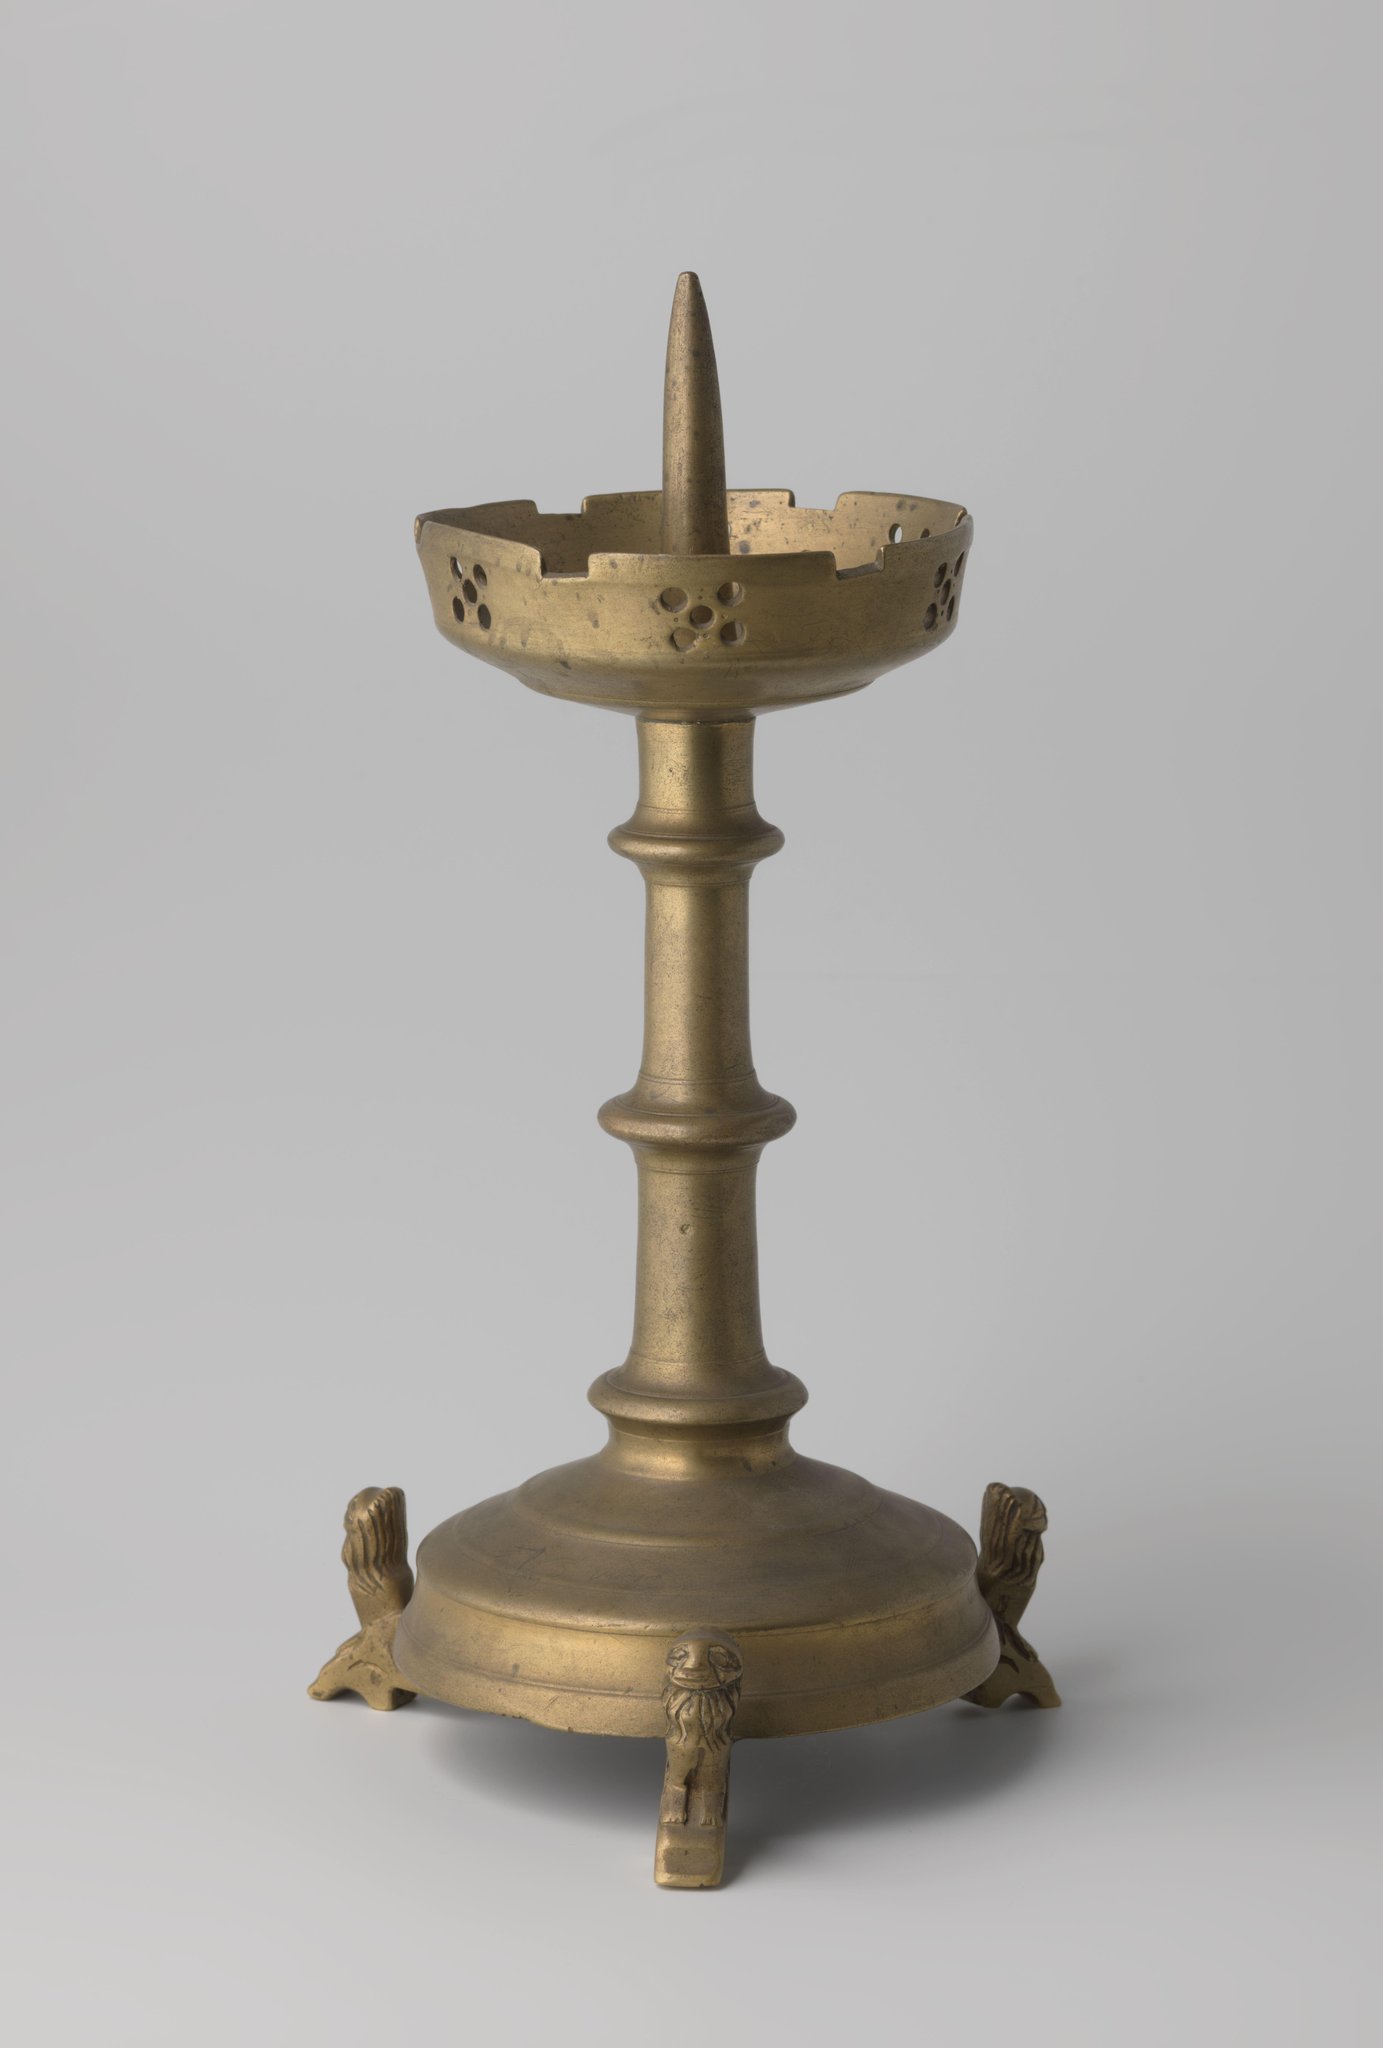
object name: candlestick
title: Kandelaar, gedragen door leeuwen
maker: Anonymous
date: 1400-1500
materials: brass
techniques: casting, punching, soldering, turning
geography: southern netherlands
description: Het voorwerp is samengesteld uit de volgende delen: de voet en de stam die in één geheel zijn gegoten, de vetvanger, de kaarsenpin en de drie voetstukken. De stam is van binnen hol tot aan de bovenste knoop. De ronde, zich naar het midden toe iets verhogende voet gaat over in de ronde stam met drie knopen. Hierop sluit de ronde vetvanger aan, die bijna dezelfde doorsnede heeft als de voet, en waarvan de bodem iets toeloopt. De opstaande rand met zes kantelen is verlevendigd met zes ornamenten, bestaande uit een perforatie in de vorm van een vijfpas. Bovenop is de forse kaarsenpin aangebracht. Voet, stam, vetvanger en pin zijn versierd met fijne gegroefde ringen. De kandelaar heeft onder aan de binnenkant drie nokken, waaraan de drie voetstukken in de vorm van leeuwtjes zijn gesoldeerd. Deze zijn niet oorspronkelijk en later aangebracht.